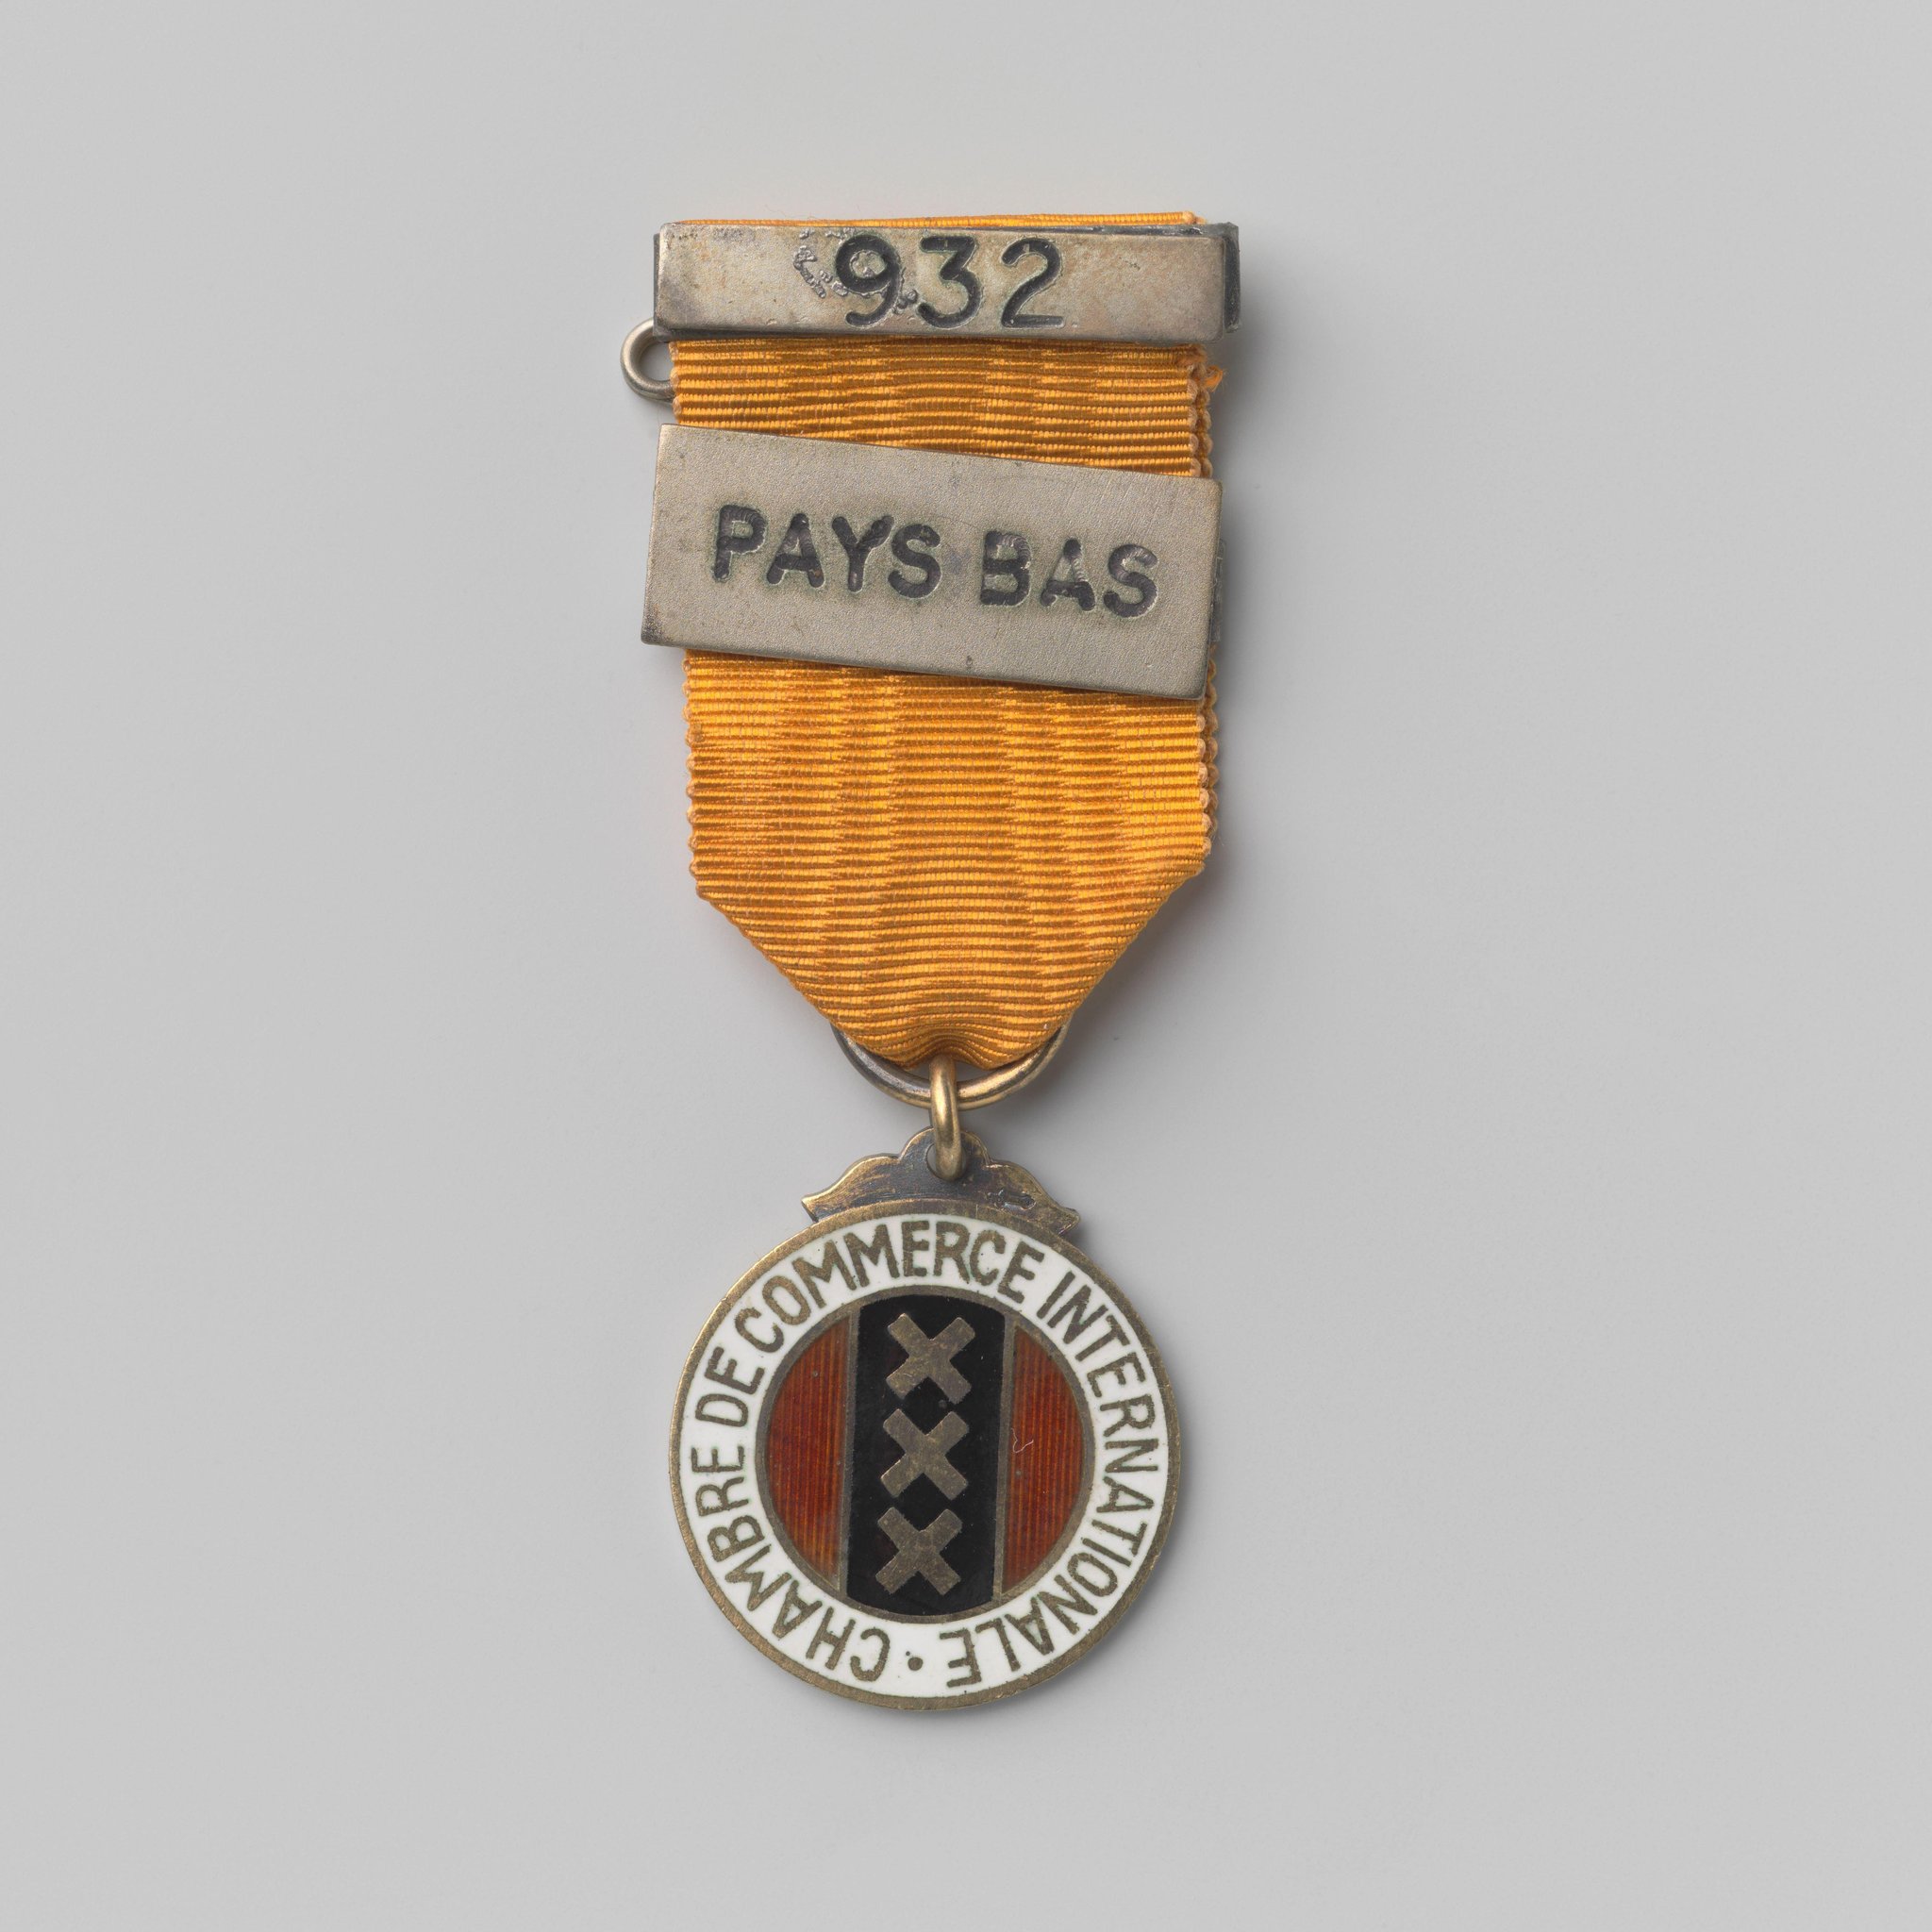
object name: insignia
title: Draagteken van het Vijfde Congres van de Internationale Kamer van Koophandel te Amsterdam 1929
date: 1929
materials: silver, textile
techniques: striking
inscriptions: inscription: ‘Vme CONGRES / AMSTERDAM / 1929’, inscription: ‘PAYS BAS’, inscription: ‘932’, circumscription: ‘CHAMBRE DE COMMERCE INTERNATIONALE’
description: Geëmailleerde penning met draagoog, via een oranje lint met gesp bevestigd aan een broche, op de voorzijde het Amsterdamse stadswapen in het veld met omschrift, op de keerzijde drie regels tekst met onder en boven ornamenten.